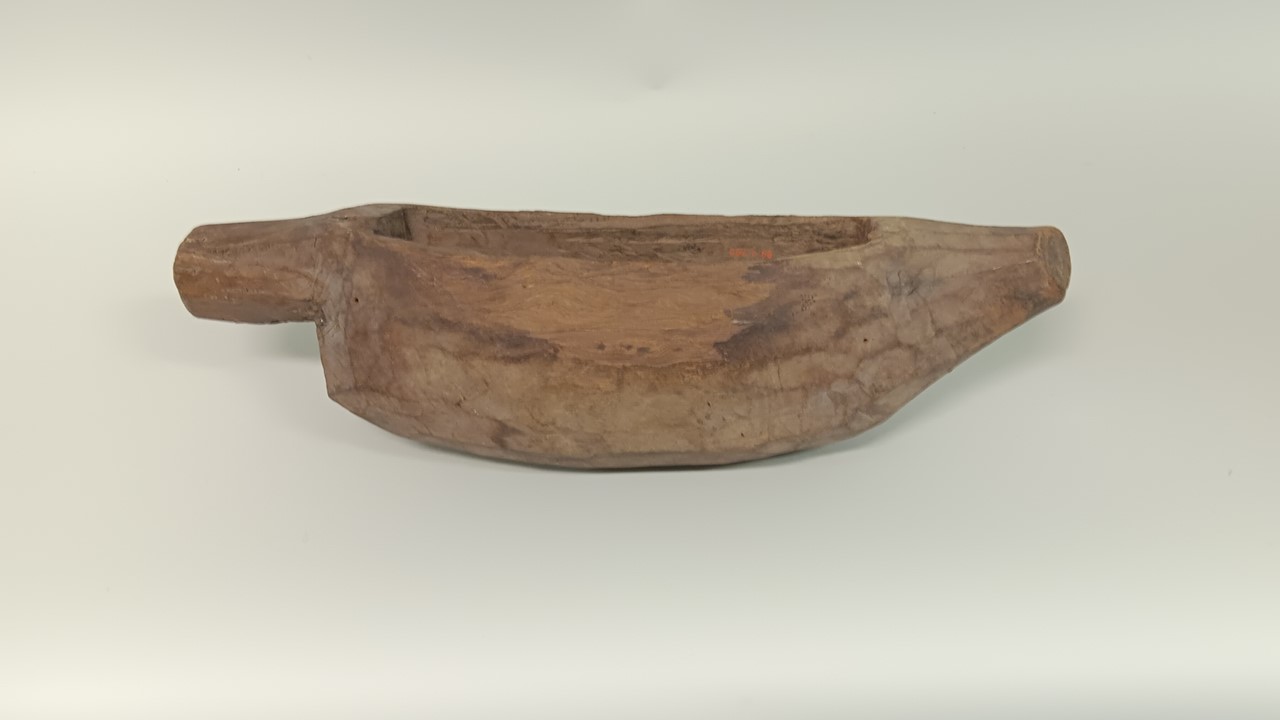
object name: drum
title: Slit Drum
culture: melanesian, aneityum island or vanuatu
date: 1867-1900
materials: wood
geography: vanuatu